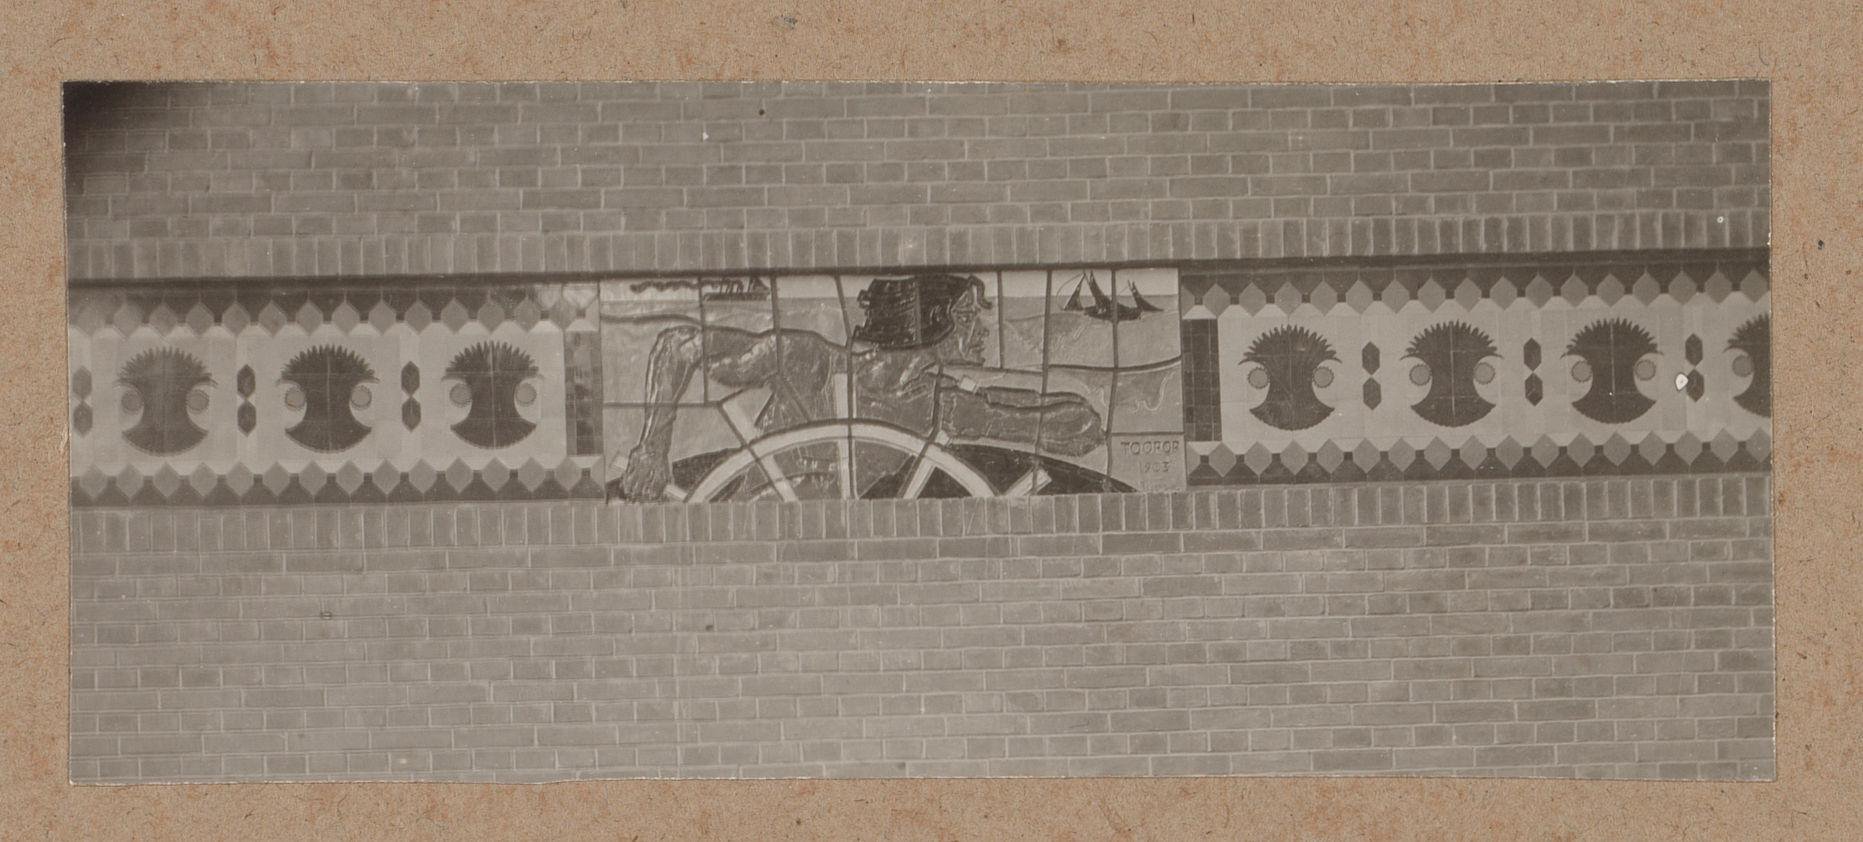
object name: photograph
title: Tegeltableau van een schipper in de Beurs van Berlage te Amsterdam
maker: Anonymous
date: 1903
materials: paper, cardboard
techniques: gelatin silver print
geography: amsterdam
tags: stock exchange, stock-market, work of applied art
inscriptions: number: ‘18 a b’